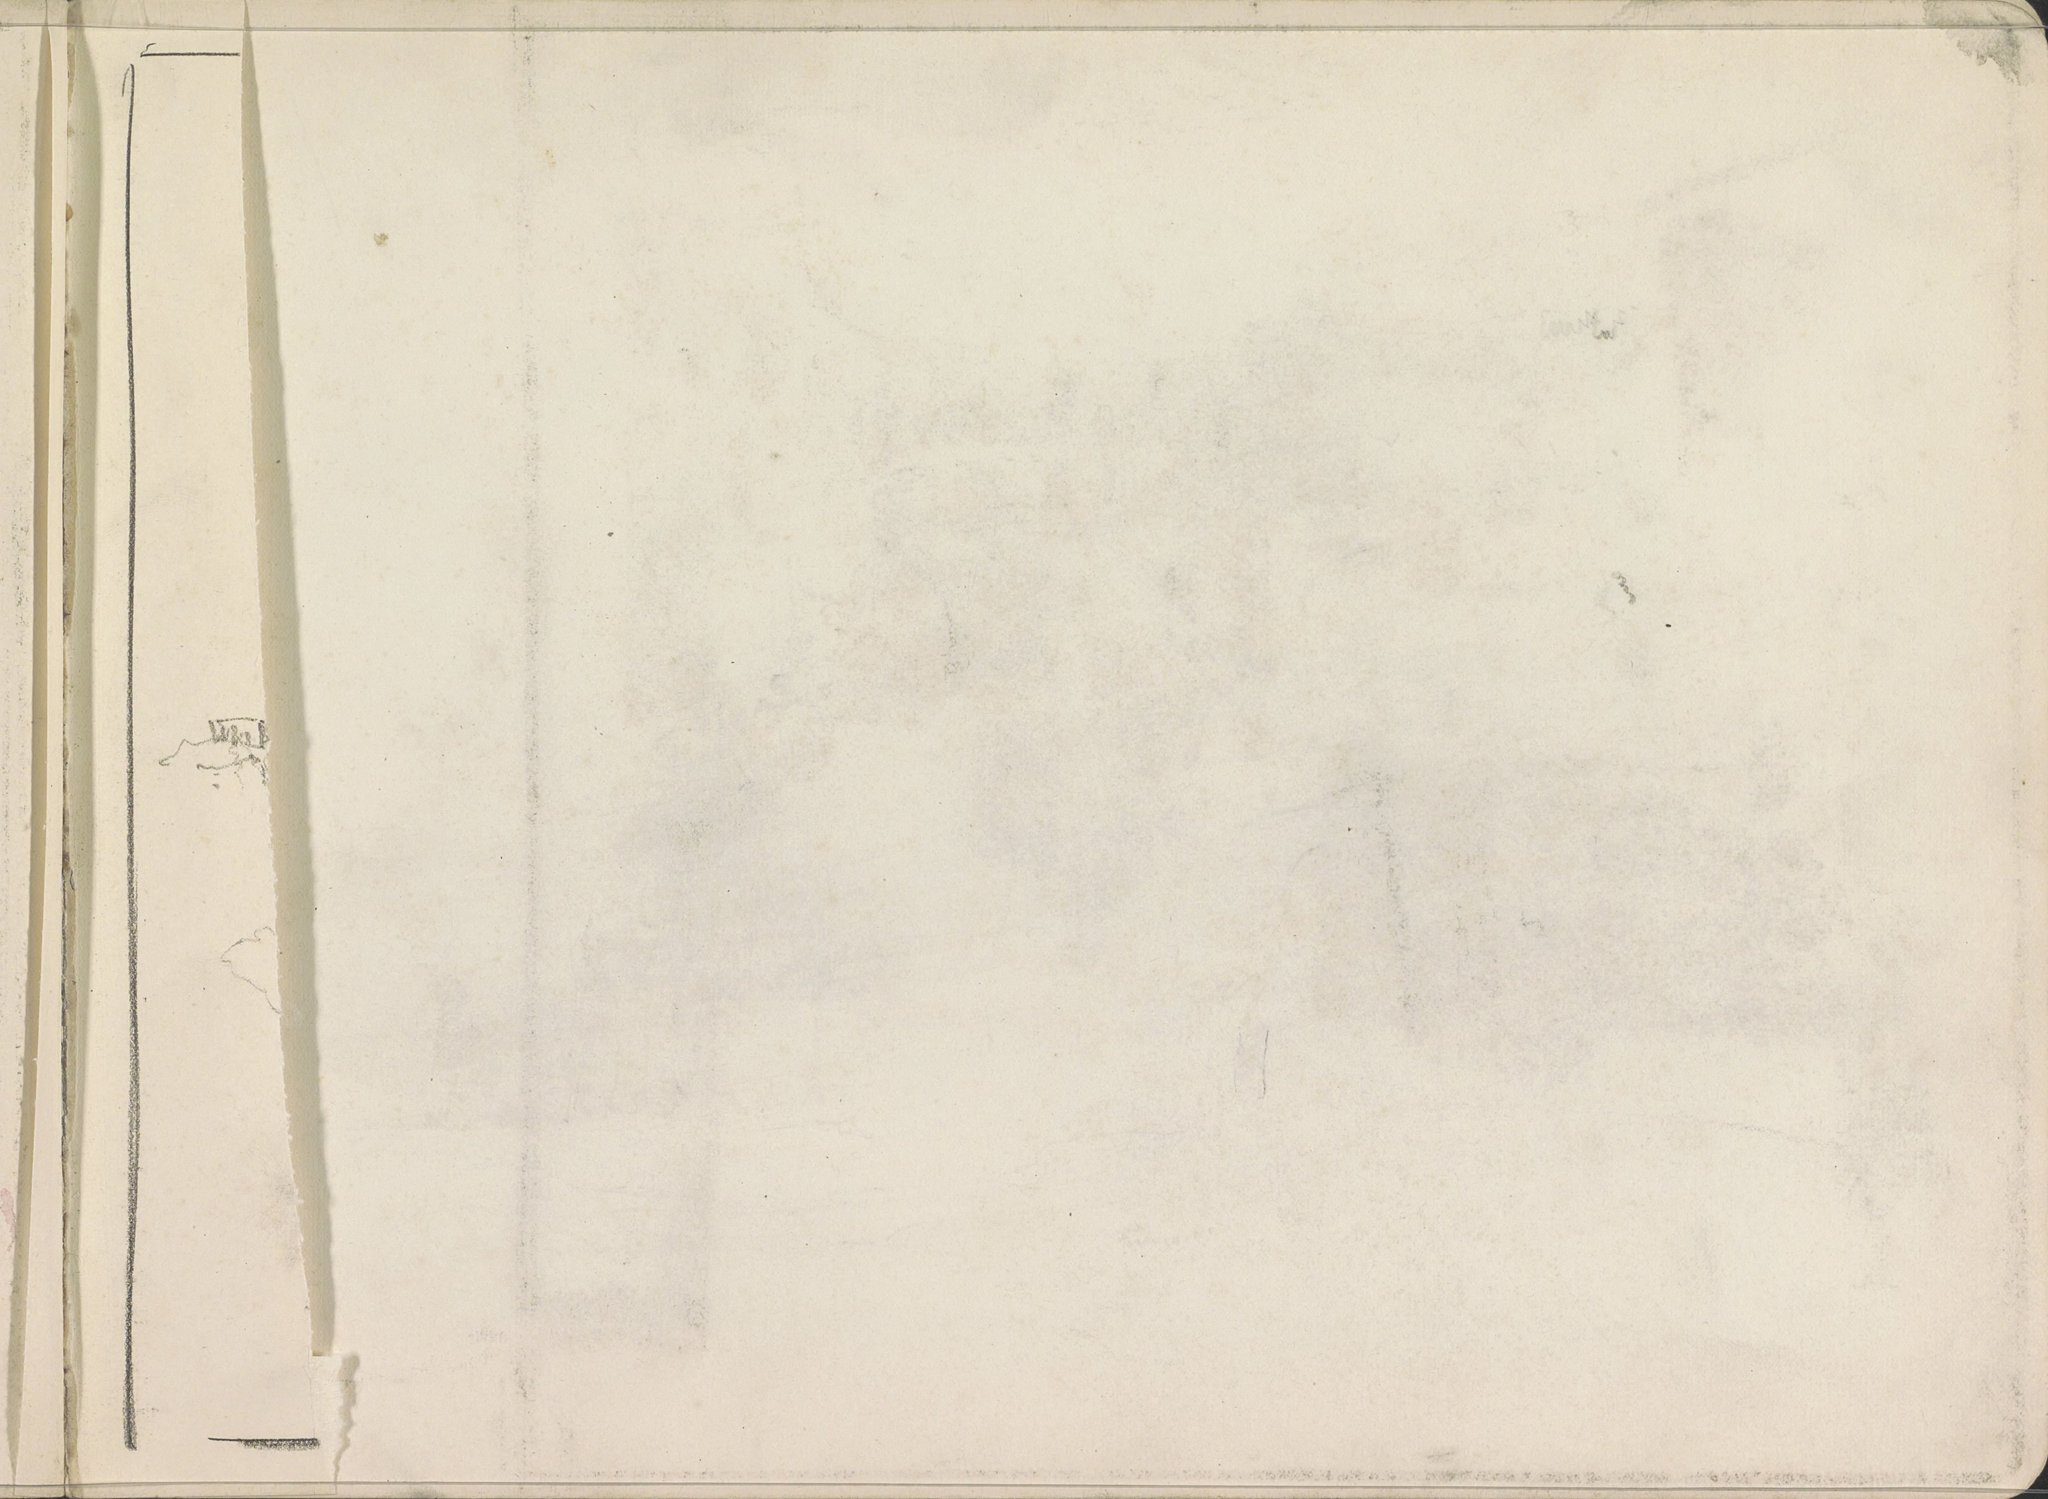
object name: sketchbook leaf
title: Studie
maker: cornelis vreedenburgh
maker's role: draughtsman, print maker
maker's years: 1880-1946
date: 1890-1946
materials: paper, pencil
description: Het blad is grotendeels uit het schetsboek gescheurd.